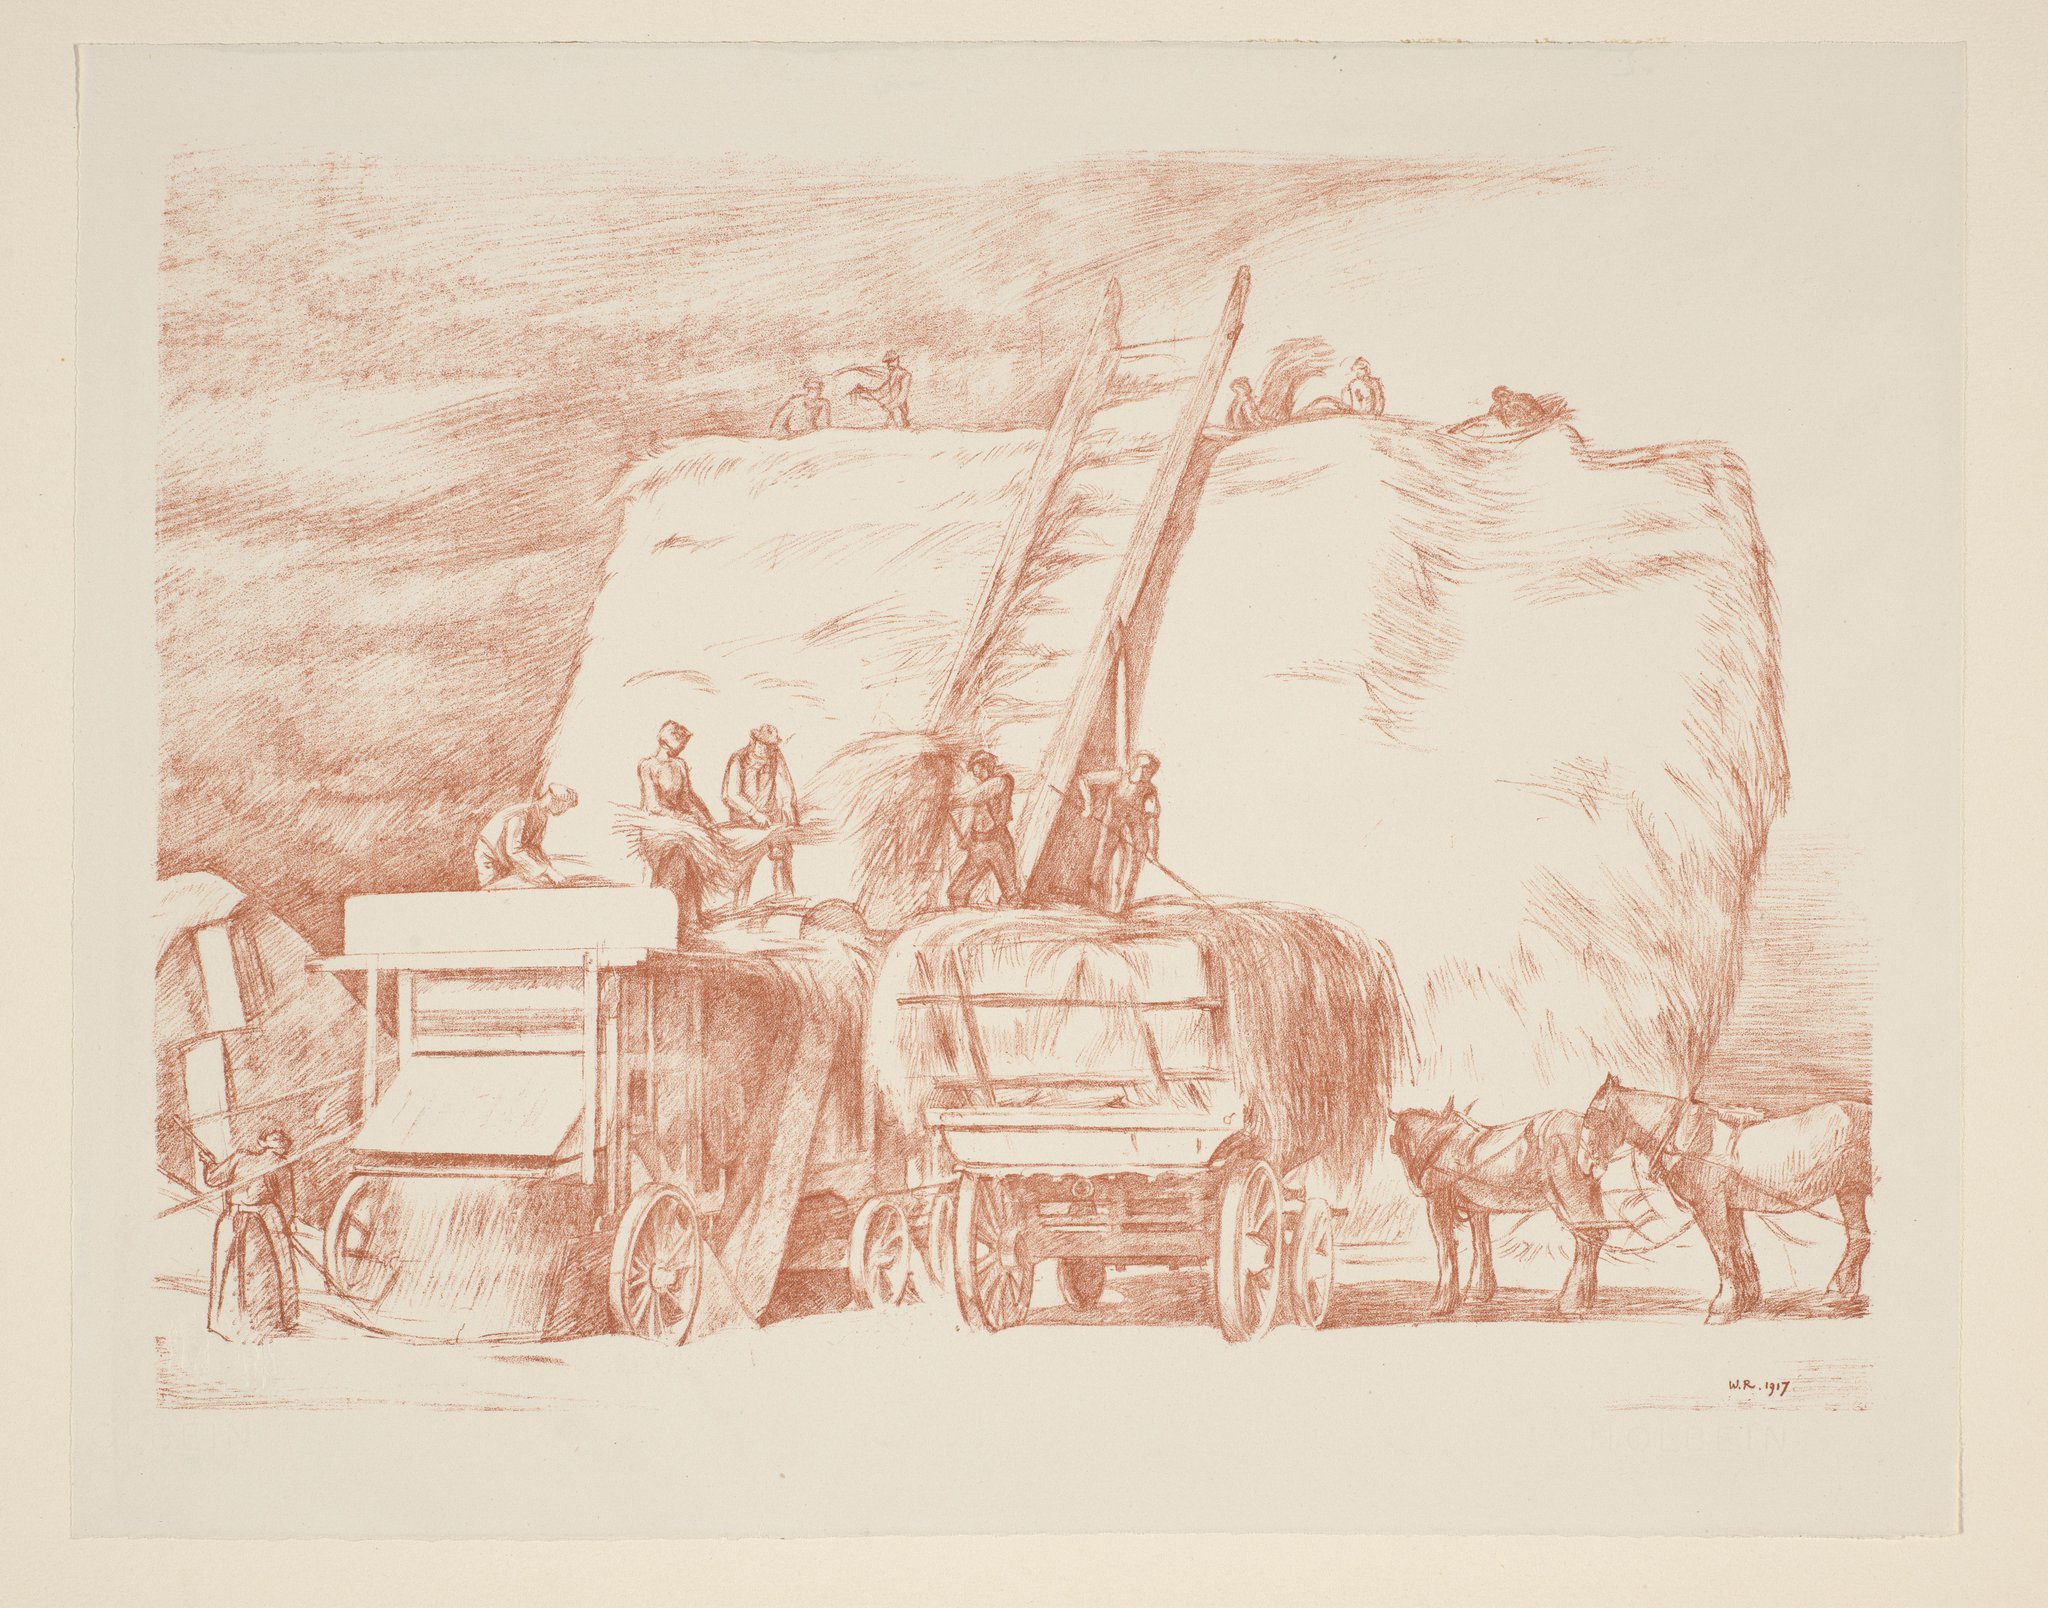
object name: print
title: Grote Oorlog: de inspanningen en idealen van Groot-Brittannië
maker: william rothenstein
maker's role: print maker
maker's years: 1872-1945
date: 1917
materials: paper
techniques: lithograph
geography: england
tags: farmers - aa - female farmer, farmer's wife, potatoes, hay-wagon, ploughing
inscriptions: watermark, watermark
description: Deze prent behoort tot de reeks 'Work on the Land' binnen de serie 'The Great War: Britain’s Efforts and Ideals'.